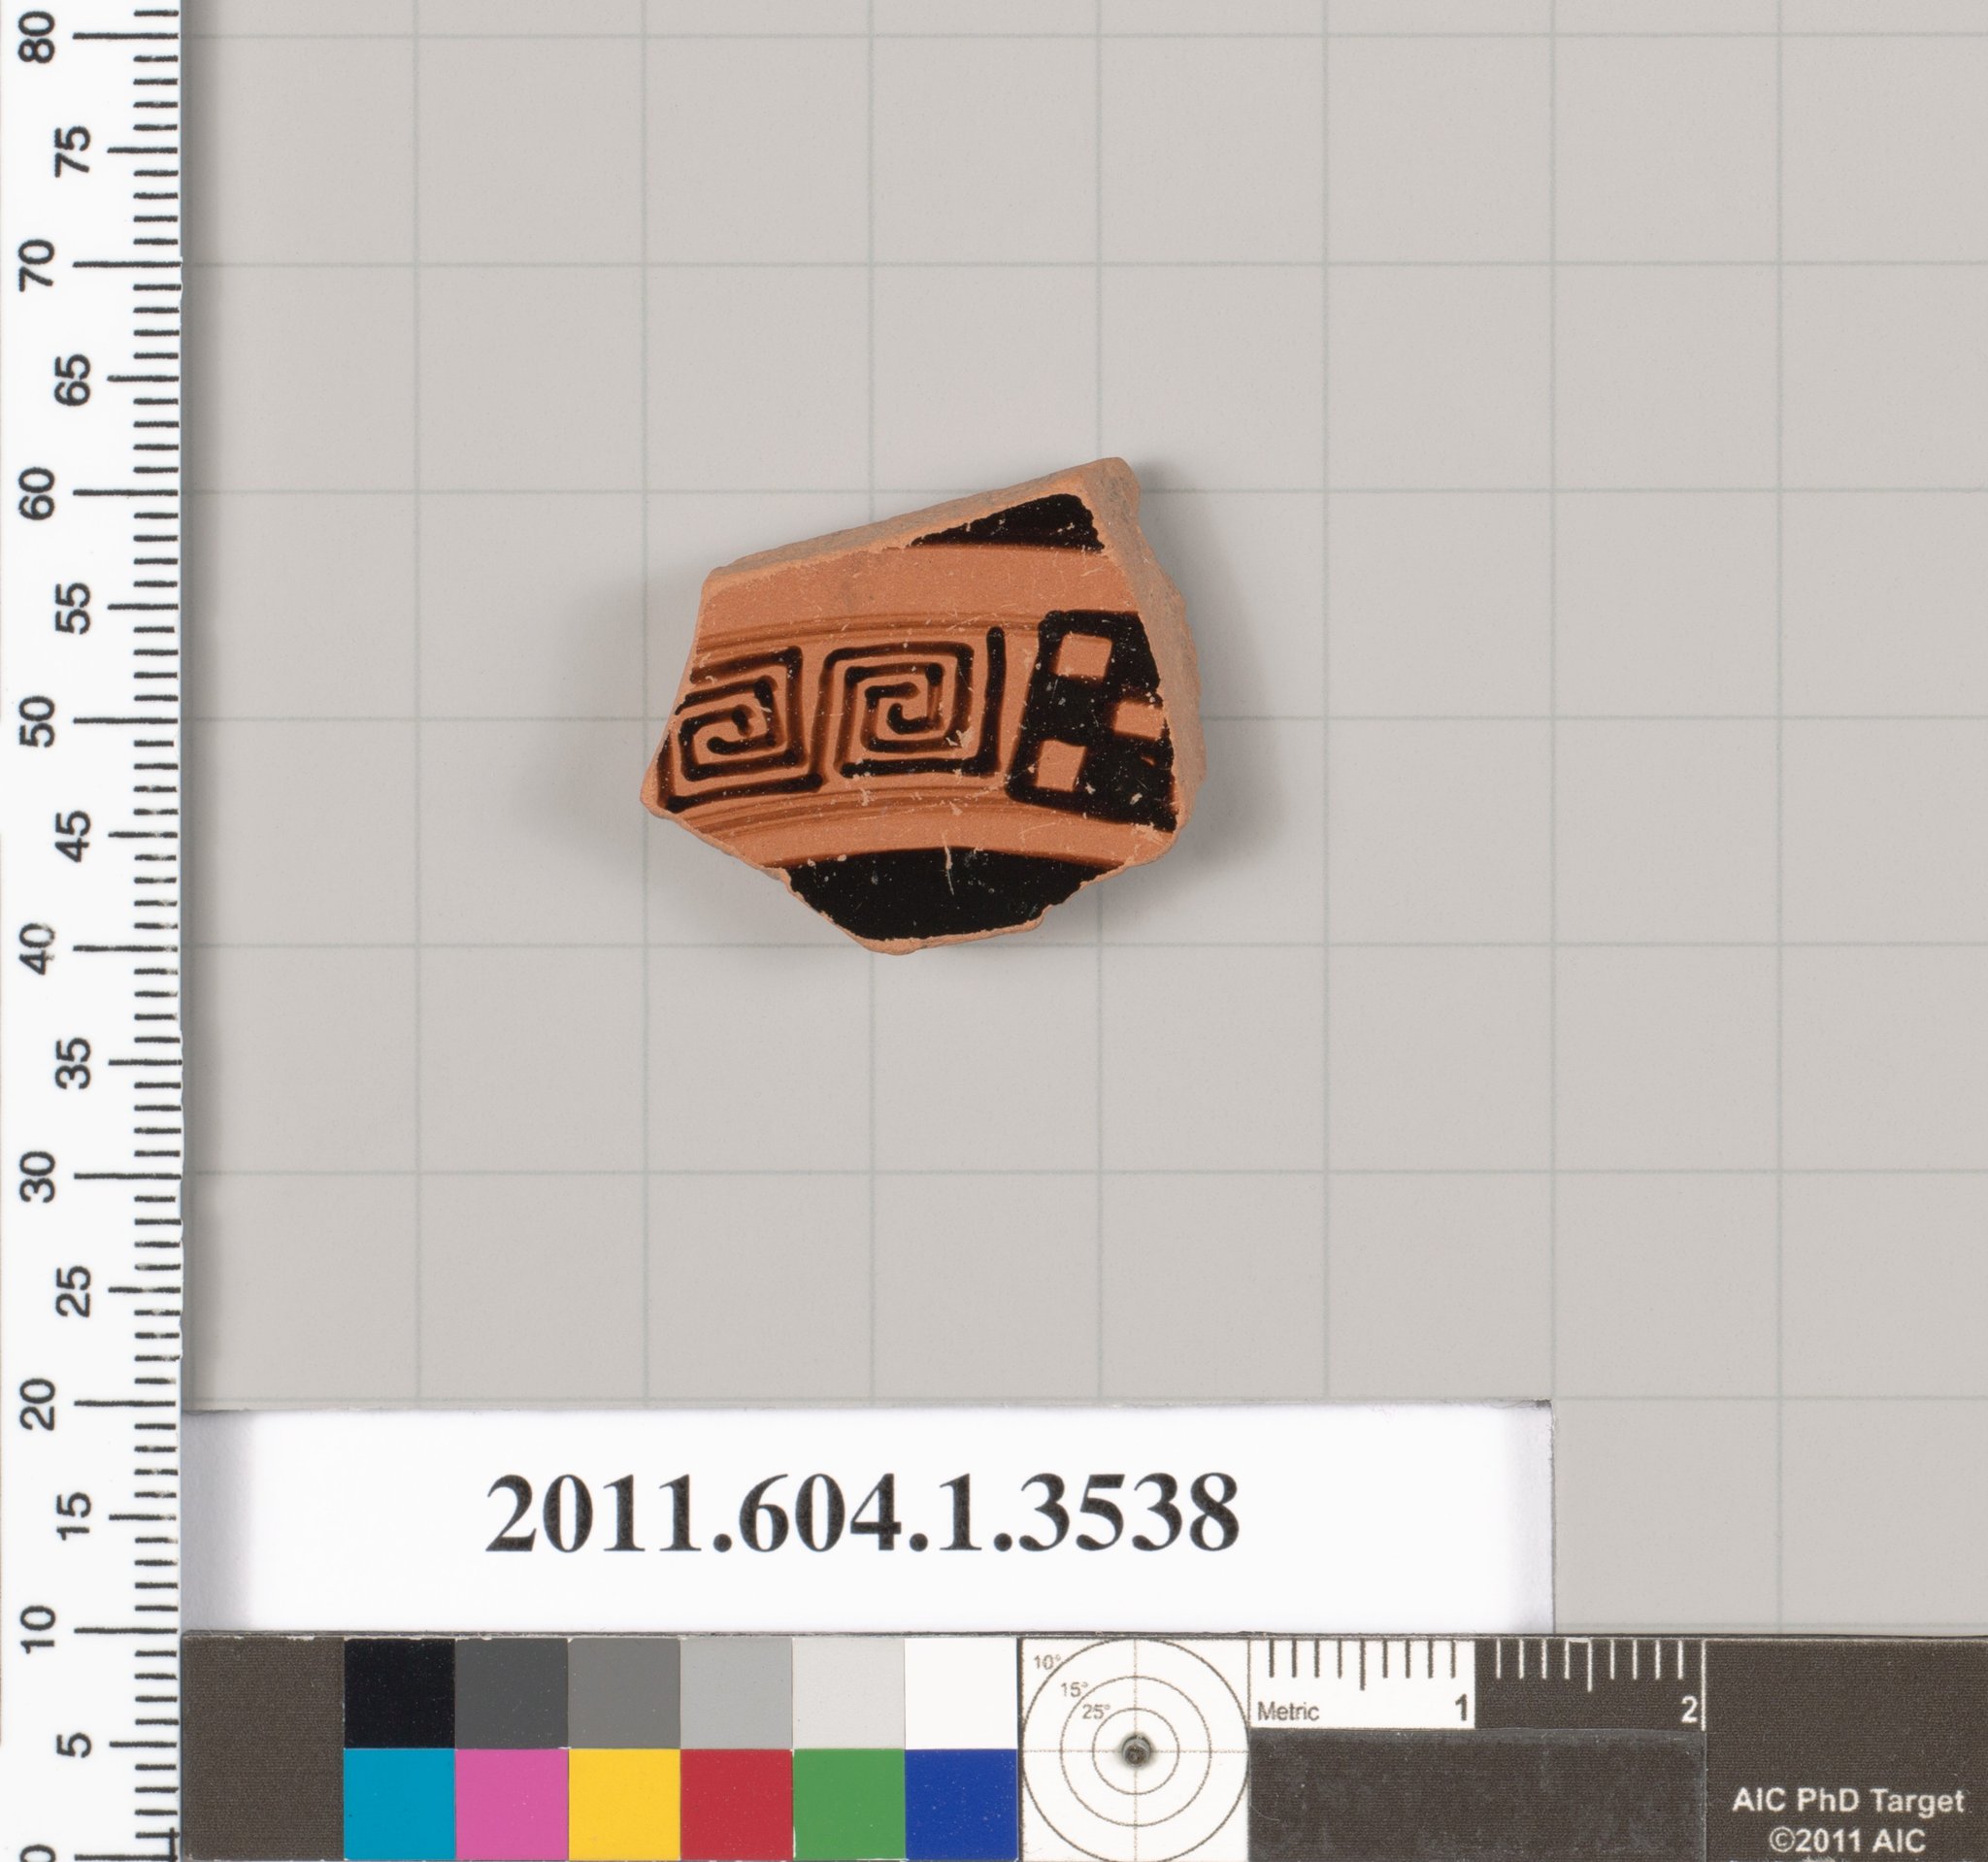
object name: kylix fragment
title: Terracotta fragment of a kylix (drinking cup)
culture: greek, attic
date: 475-451 BCE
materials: terracotta